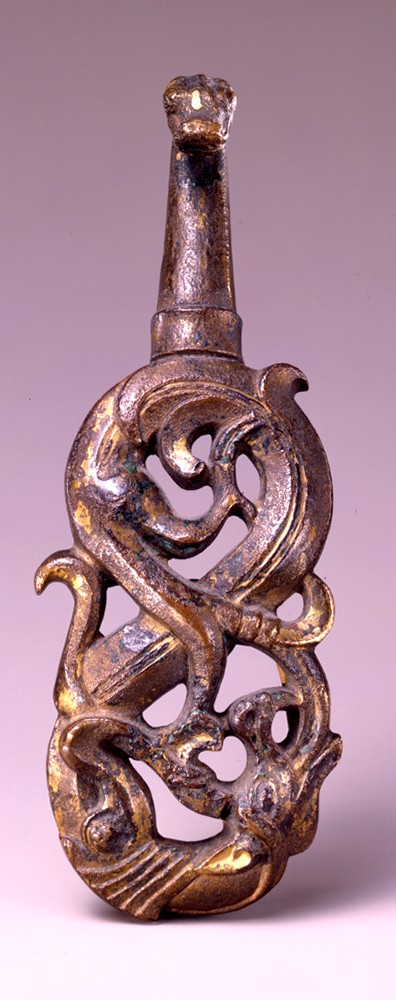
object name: belt hook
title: Belt hook in the shape of a dragon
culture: north chinese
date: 300-101 BCE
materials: gilt bronze